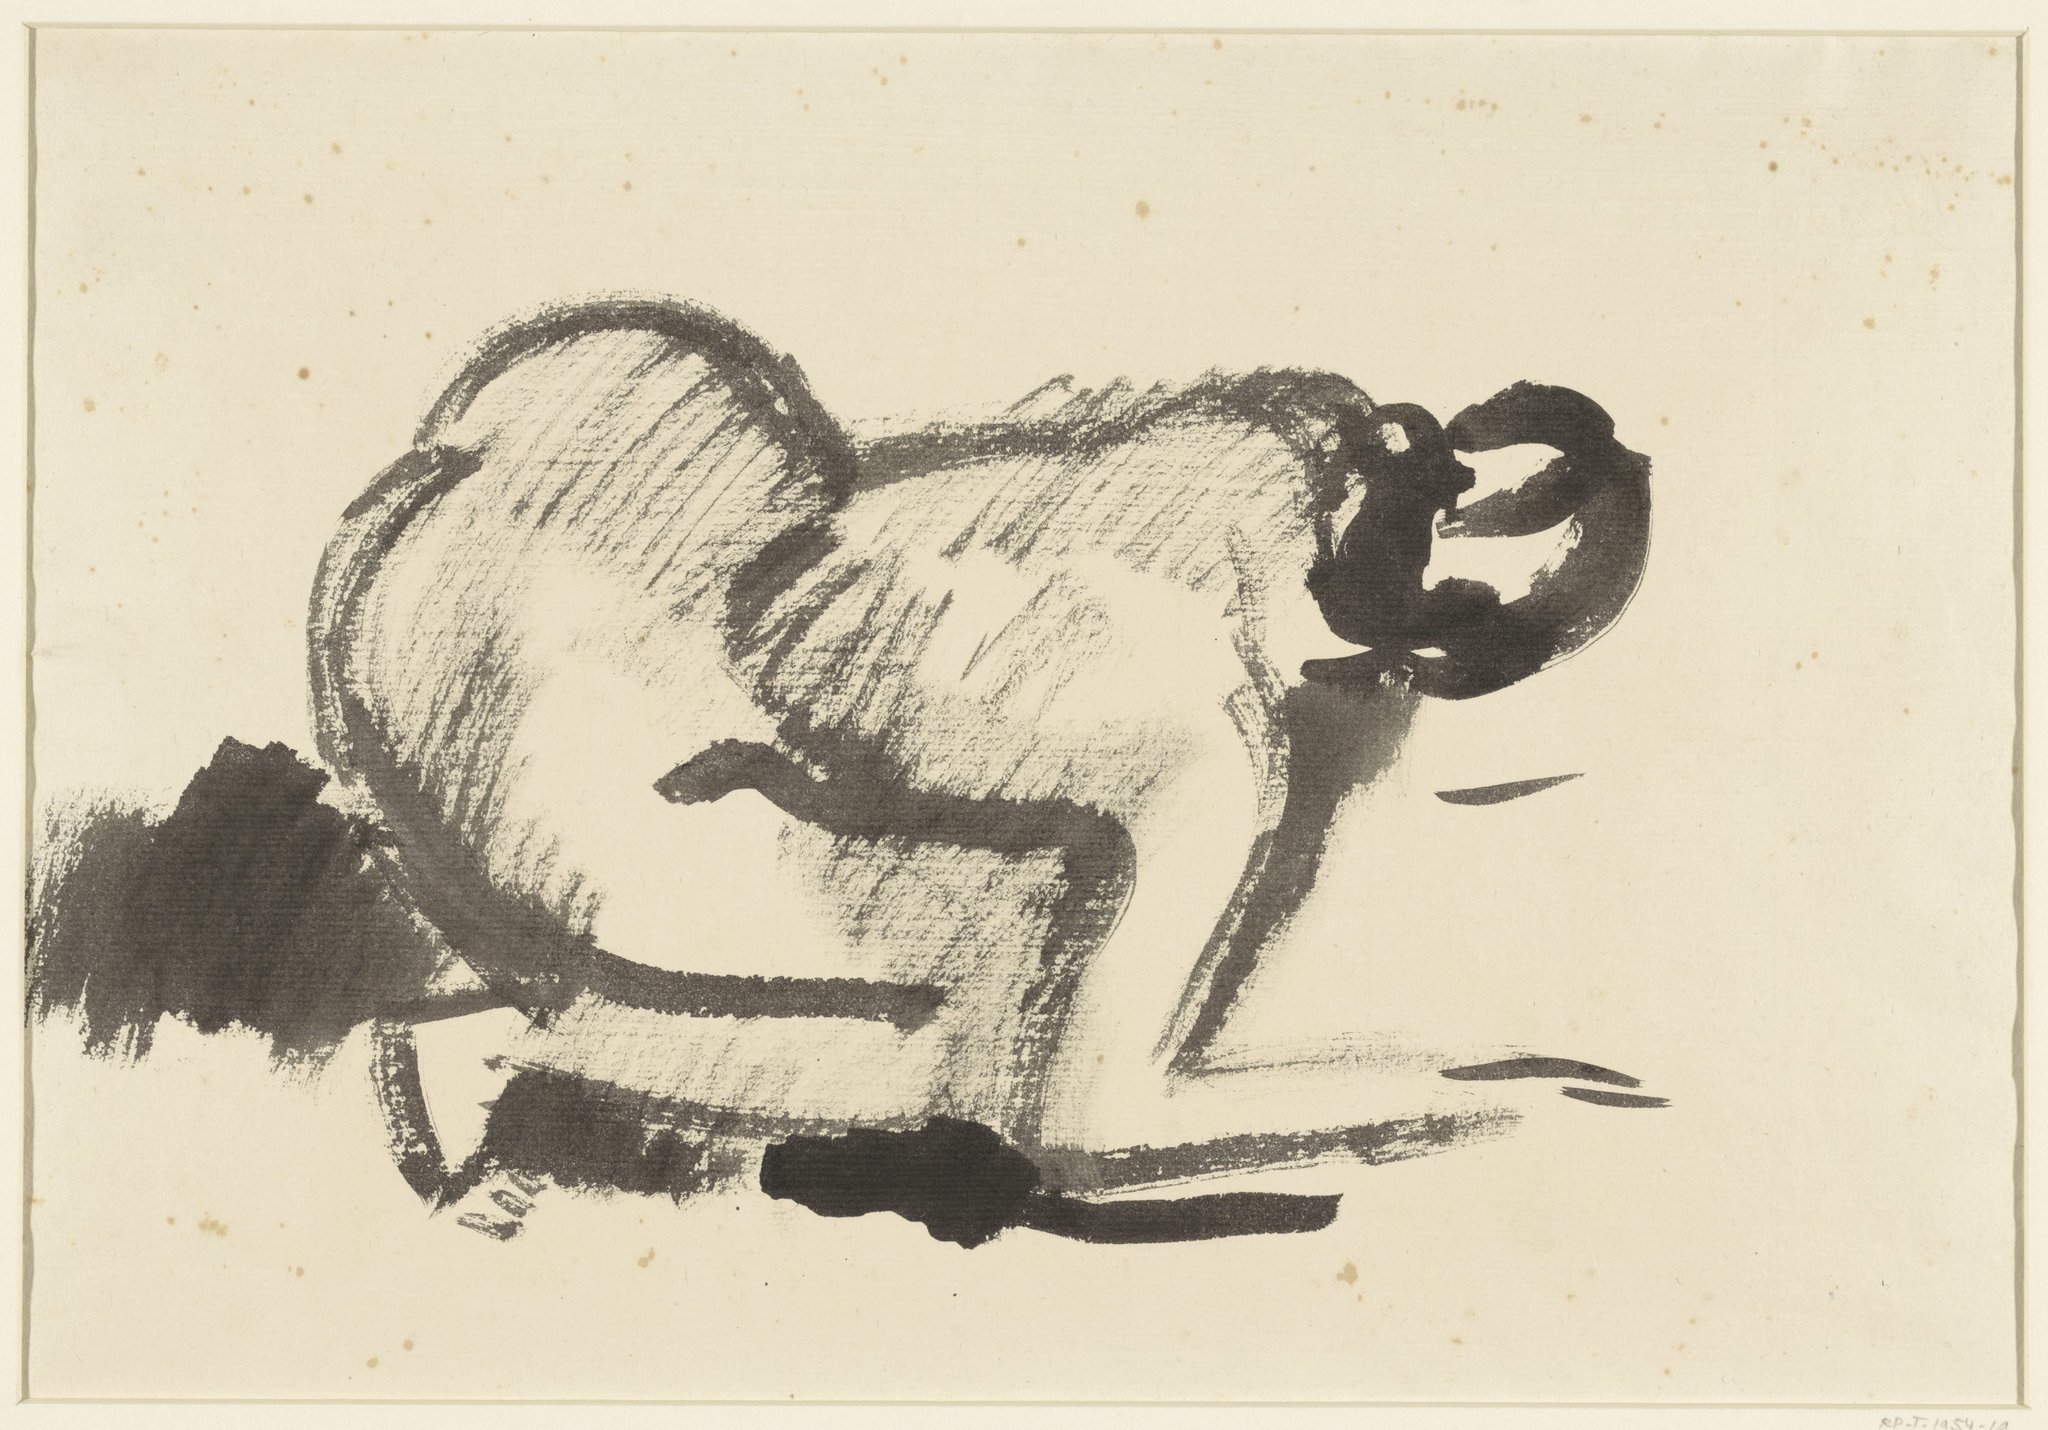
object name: drawing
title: Gehurkte naakte vrouw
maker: rik wouters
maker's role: draughtsman, print maker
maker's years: 1882-1916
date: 1892-1916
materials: paper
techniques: brush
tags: squatting, crouching figure - aa - female human figure